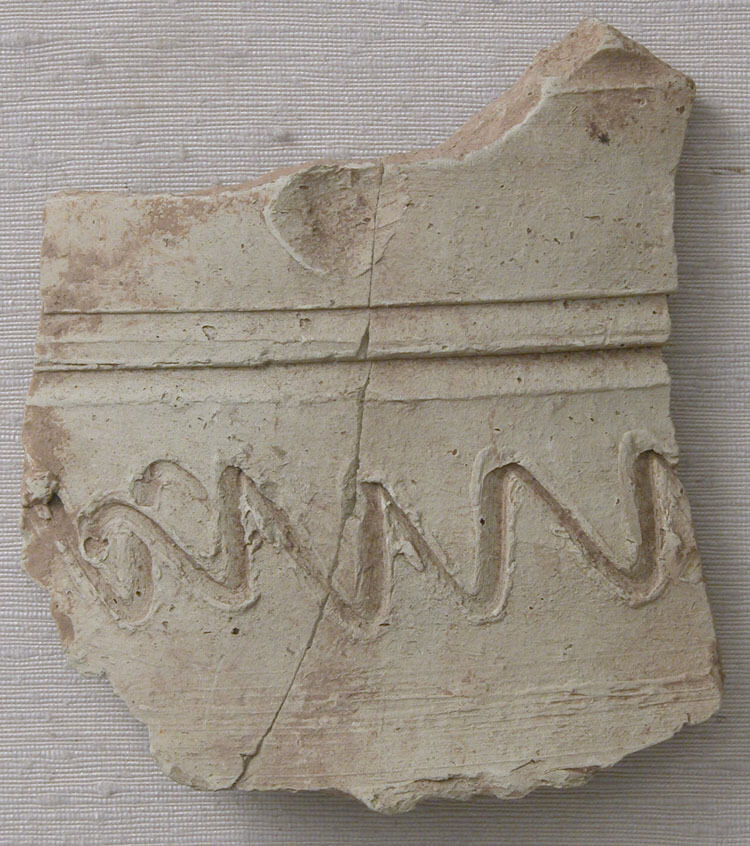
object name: fragment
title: Ceramic Fragment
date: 701-900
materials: earthenware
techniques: incising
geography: iraq